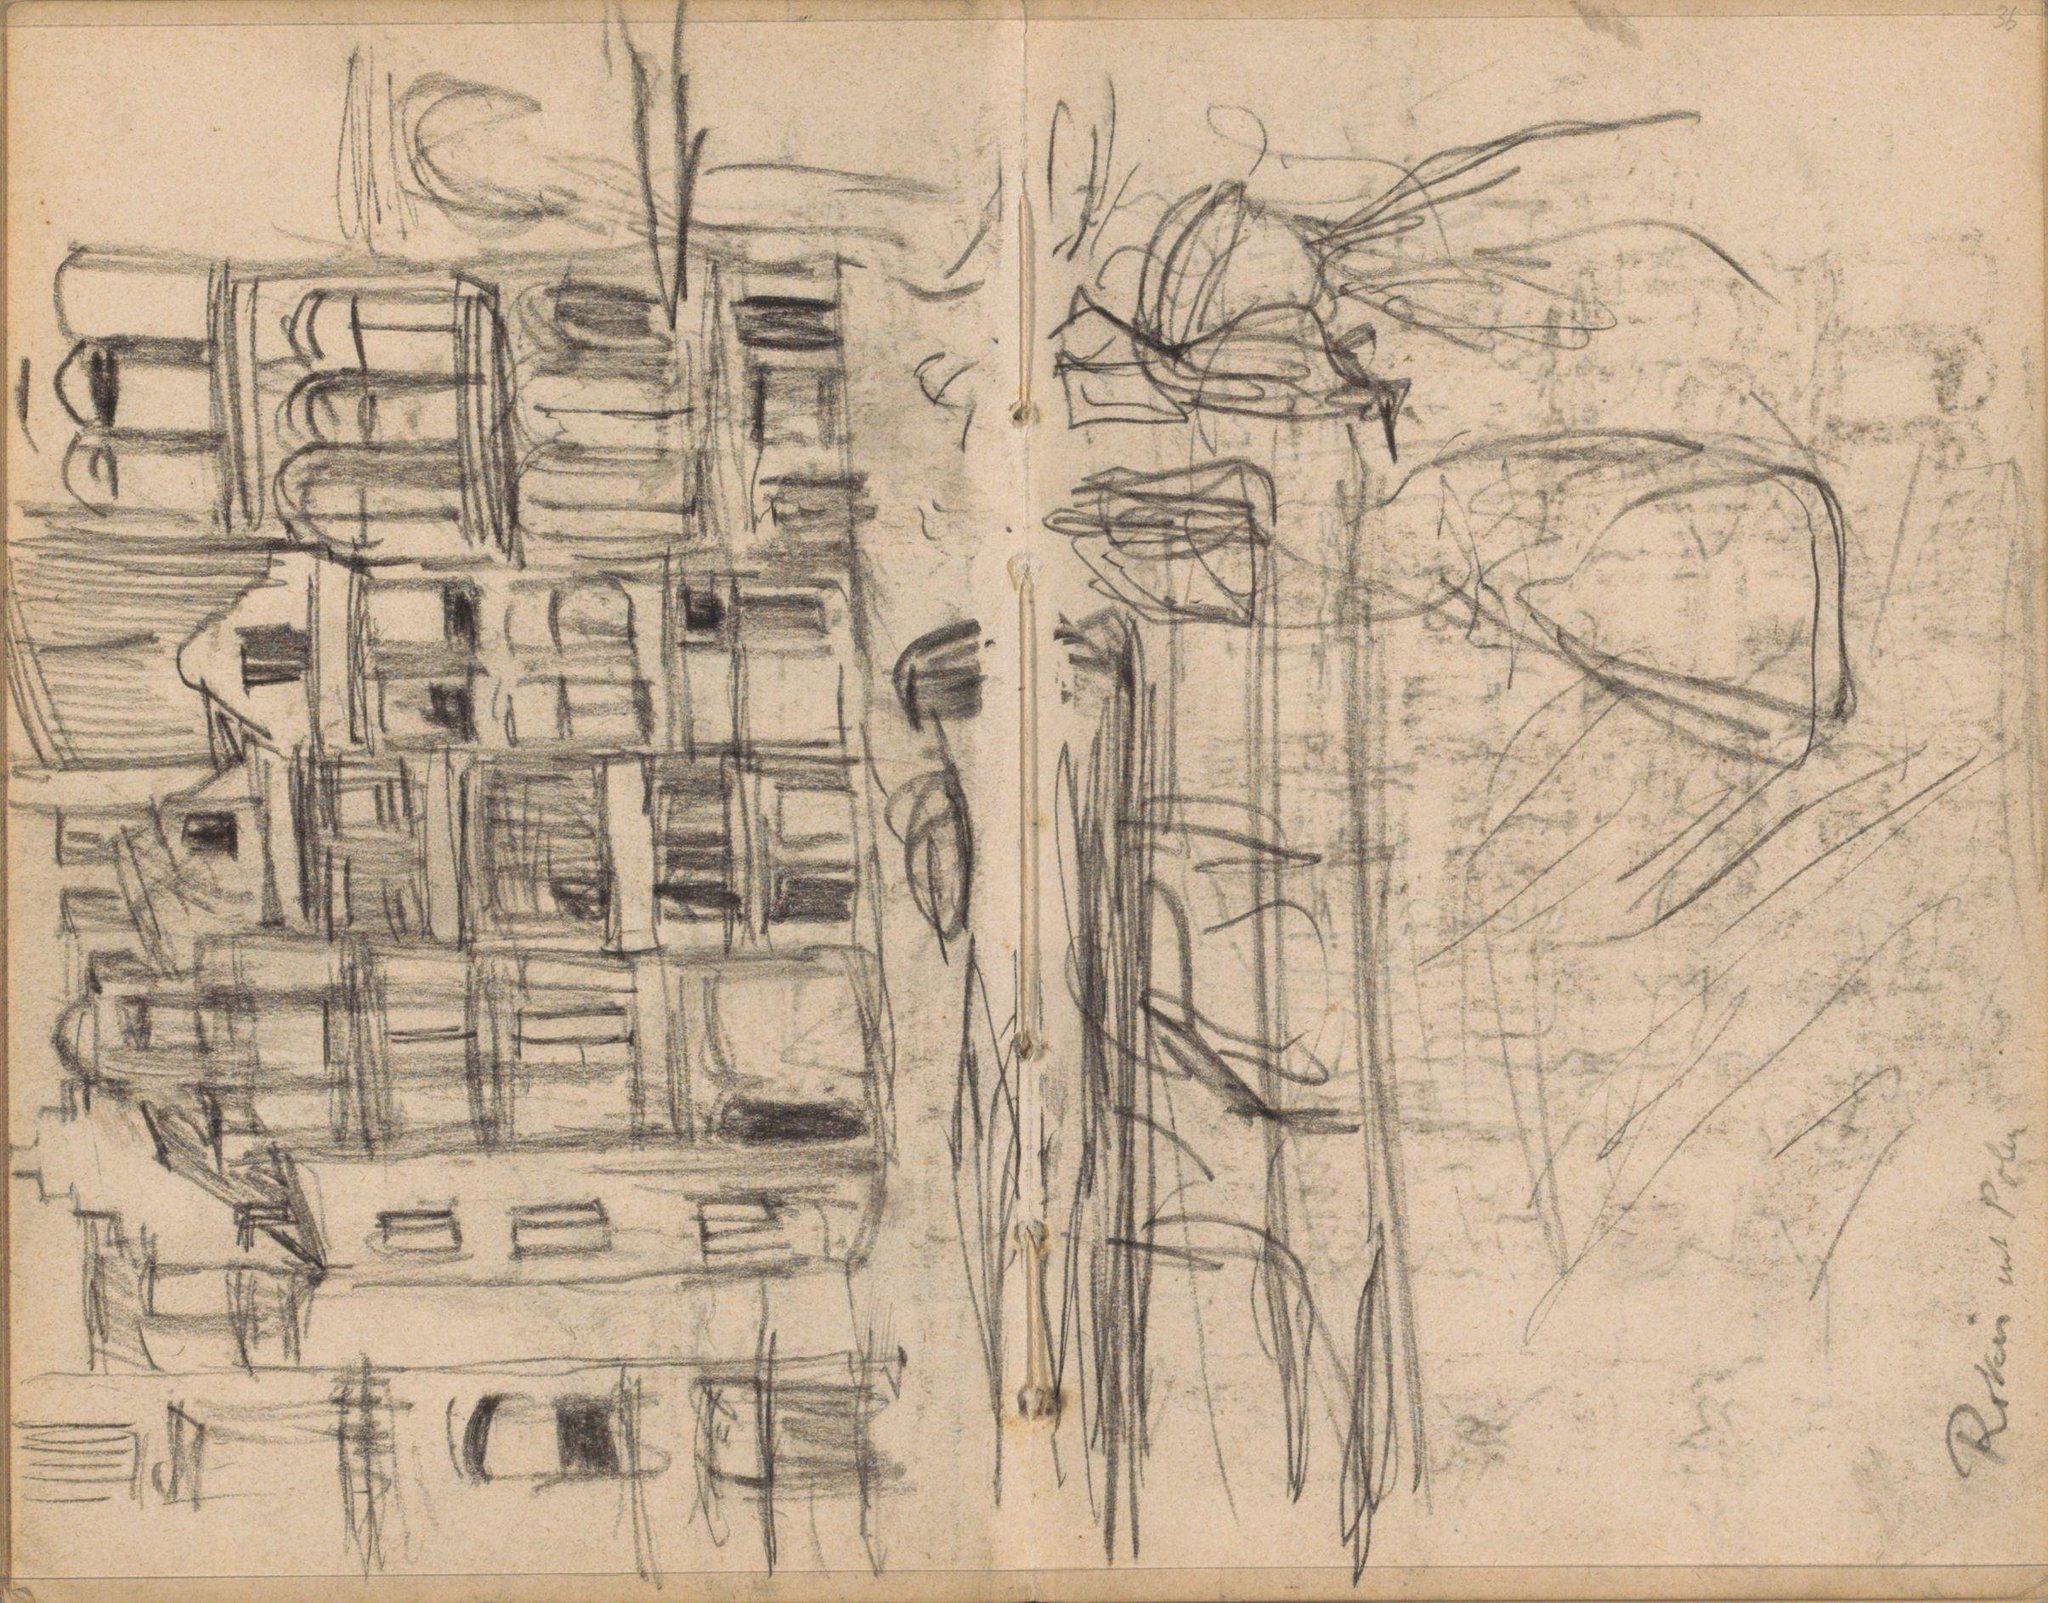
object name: sketchbook leaf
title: Gezicht op het Rokin te Amsterdam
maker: george hendrik breitner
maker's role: draughtsman, painter, print maker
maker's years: 1857-1923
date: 1902-1914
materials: chalk, paper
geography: amsterdam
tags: urban housing, street (+ city(-scape) with figures, staffage)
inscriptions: annotation: ‘Rokin uit Polen’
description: Gezicht op het Rokin te Amsterdam, gezien vanuit Rokin 14, Hotel Polen. Vooraan figuren. Pagina 35 en pagina 36 uit een schetsboek met 46 bladen vervaardigd te Noord-Holland en Utrecht.